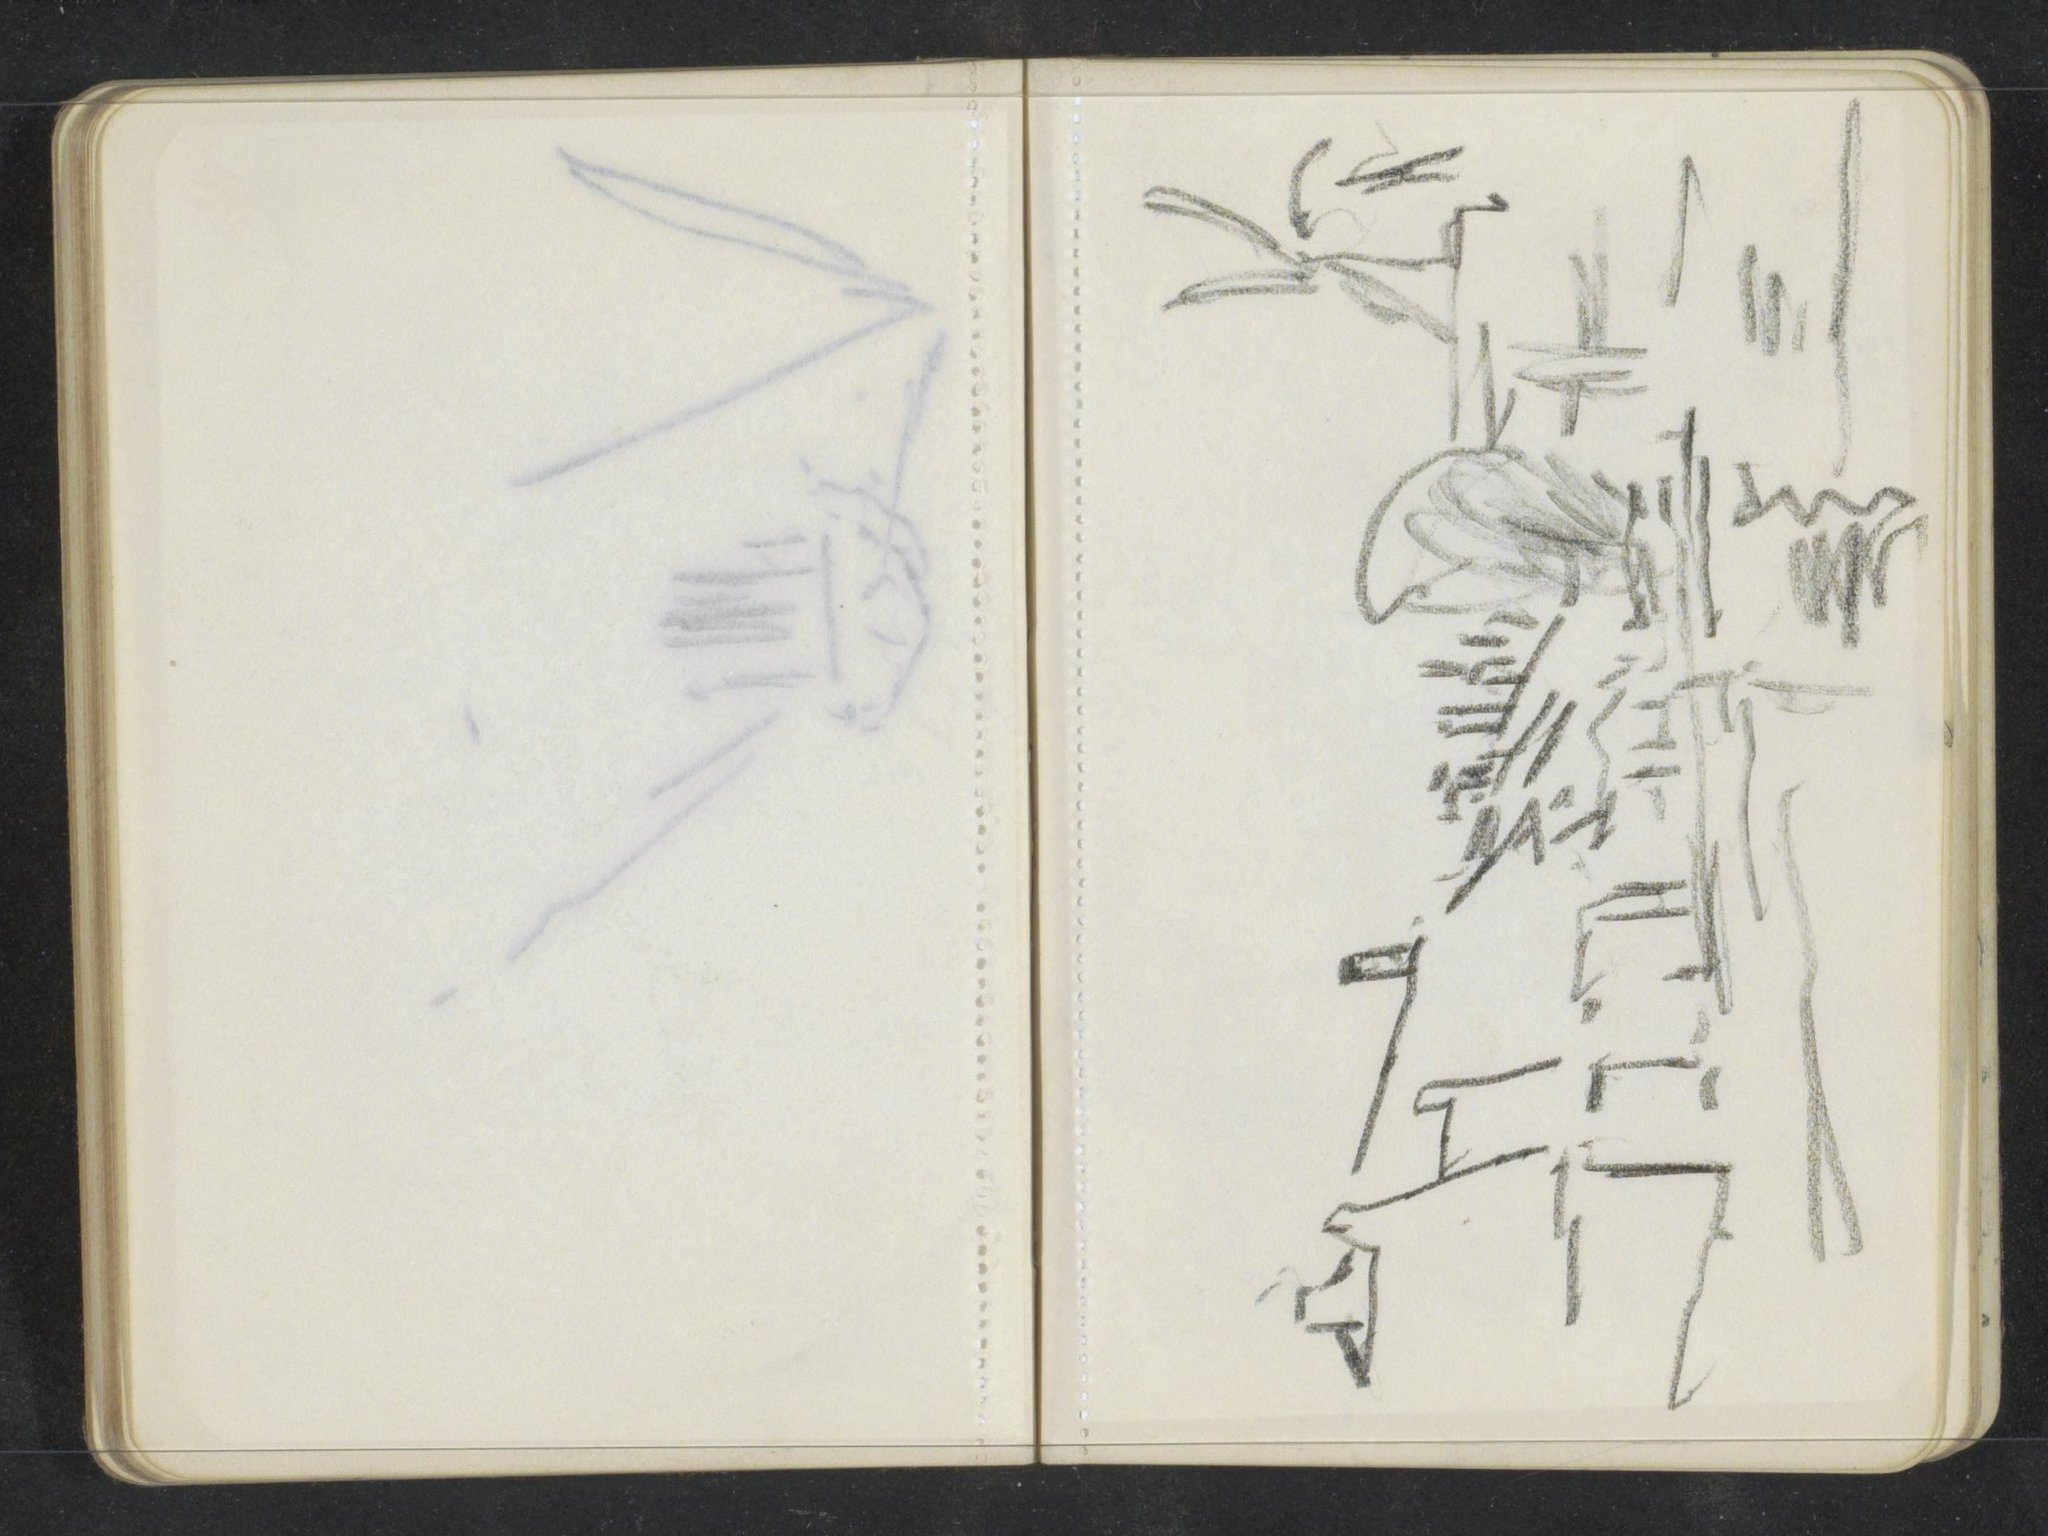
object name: sketchbook leaf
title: Rij huizen bij een molen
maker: alexander shilling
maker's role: draughtsman, print maker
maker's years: 1859-1937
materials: chalk, paper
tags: the usual house or row of houses, windmill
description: Blad 44 recto uit een schetsboek met 91 bladen.